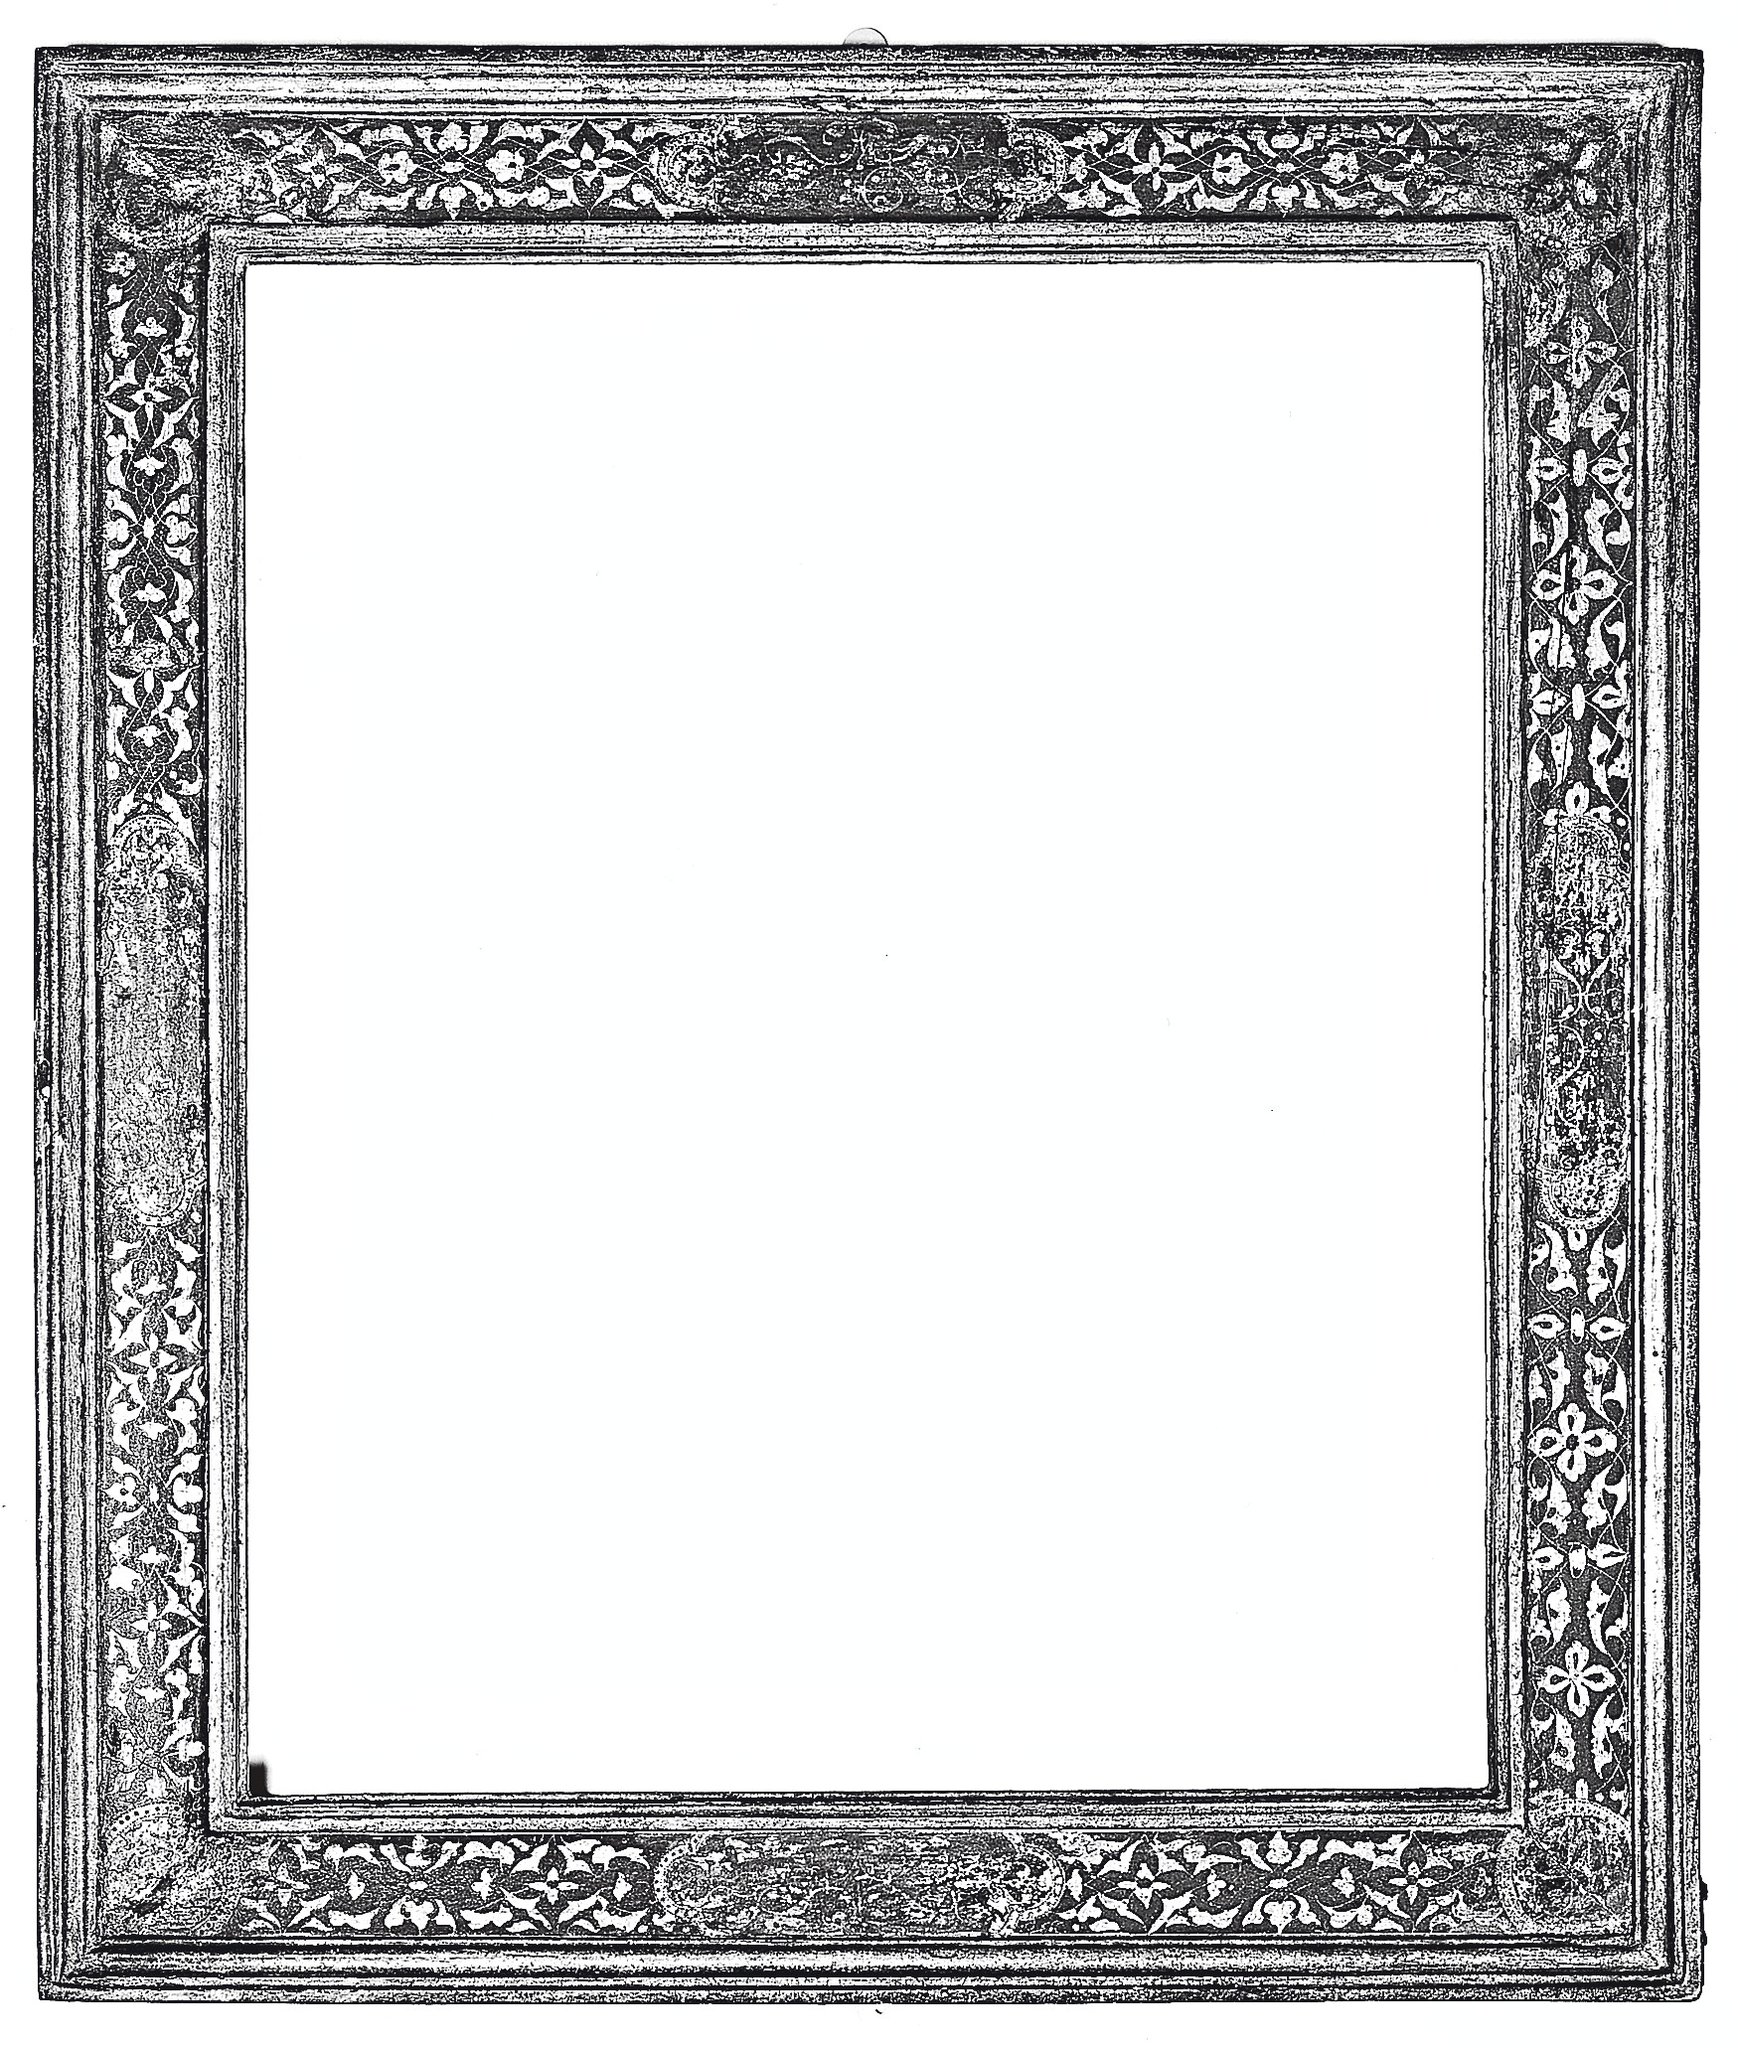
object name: frame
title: Cassetta frame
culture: italian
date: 1501-1533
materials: gilt, wood